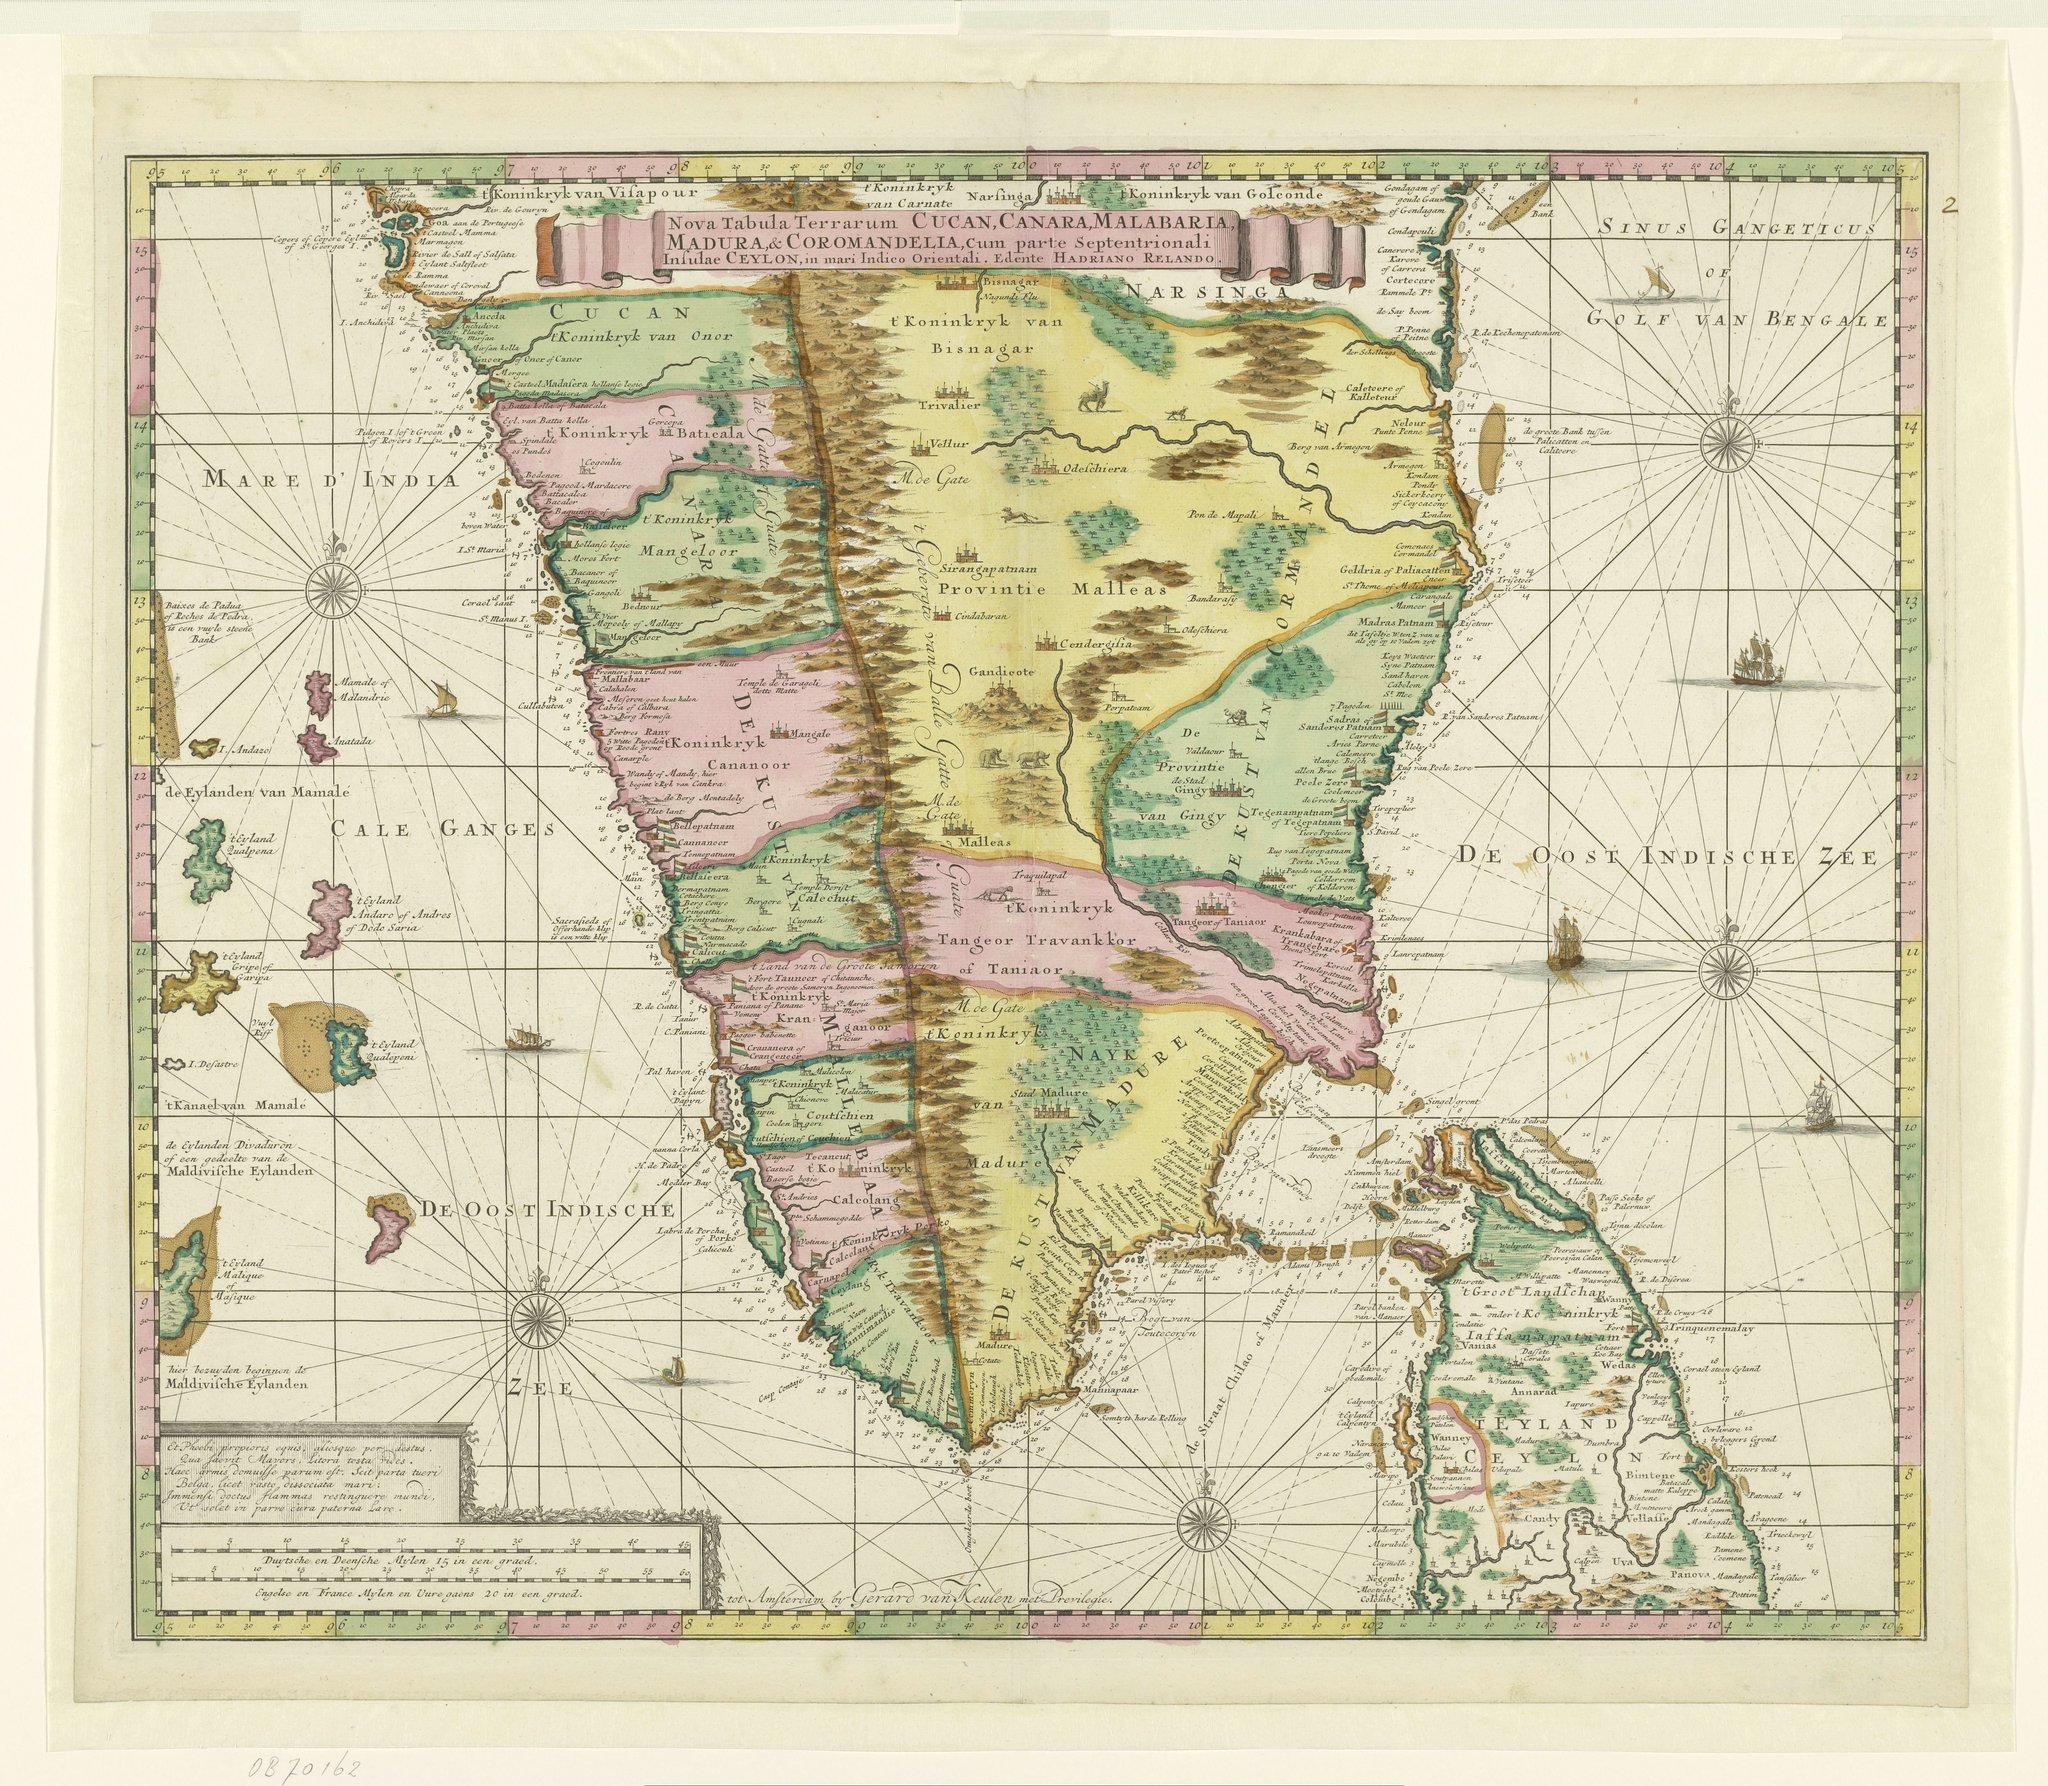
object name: print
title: Nova tabula terrarum Cucan, Canara, Malabaria, Madura, & Coromandella, cum parte septentrionali insulae Ceylon, in mari Indico Orientali / edente Hadriano Relando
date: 1720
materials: paper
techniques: engraving, hand coloring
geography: amsterdam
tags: maps of separate countries or regions, sri lanka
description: Kaart van Zuid-India met een deel van Ceylon, lopende van de 95ste tot en met de 105de breedtegraad en van de 7de tot en met de 15.20ste lengtegraad. Schaal: 1:2000.000.